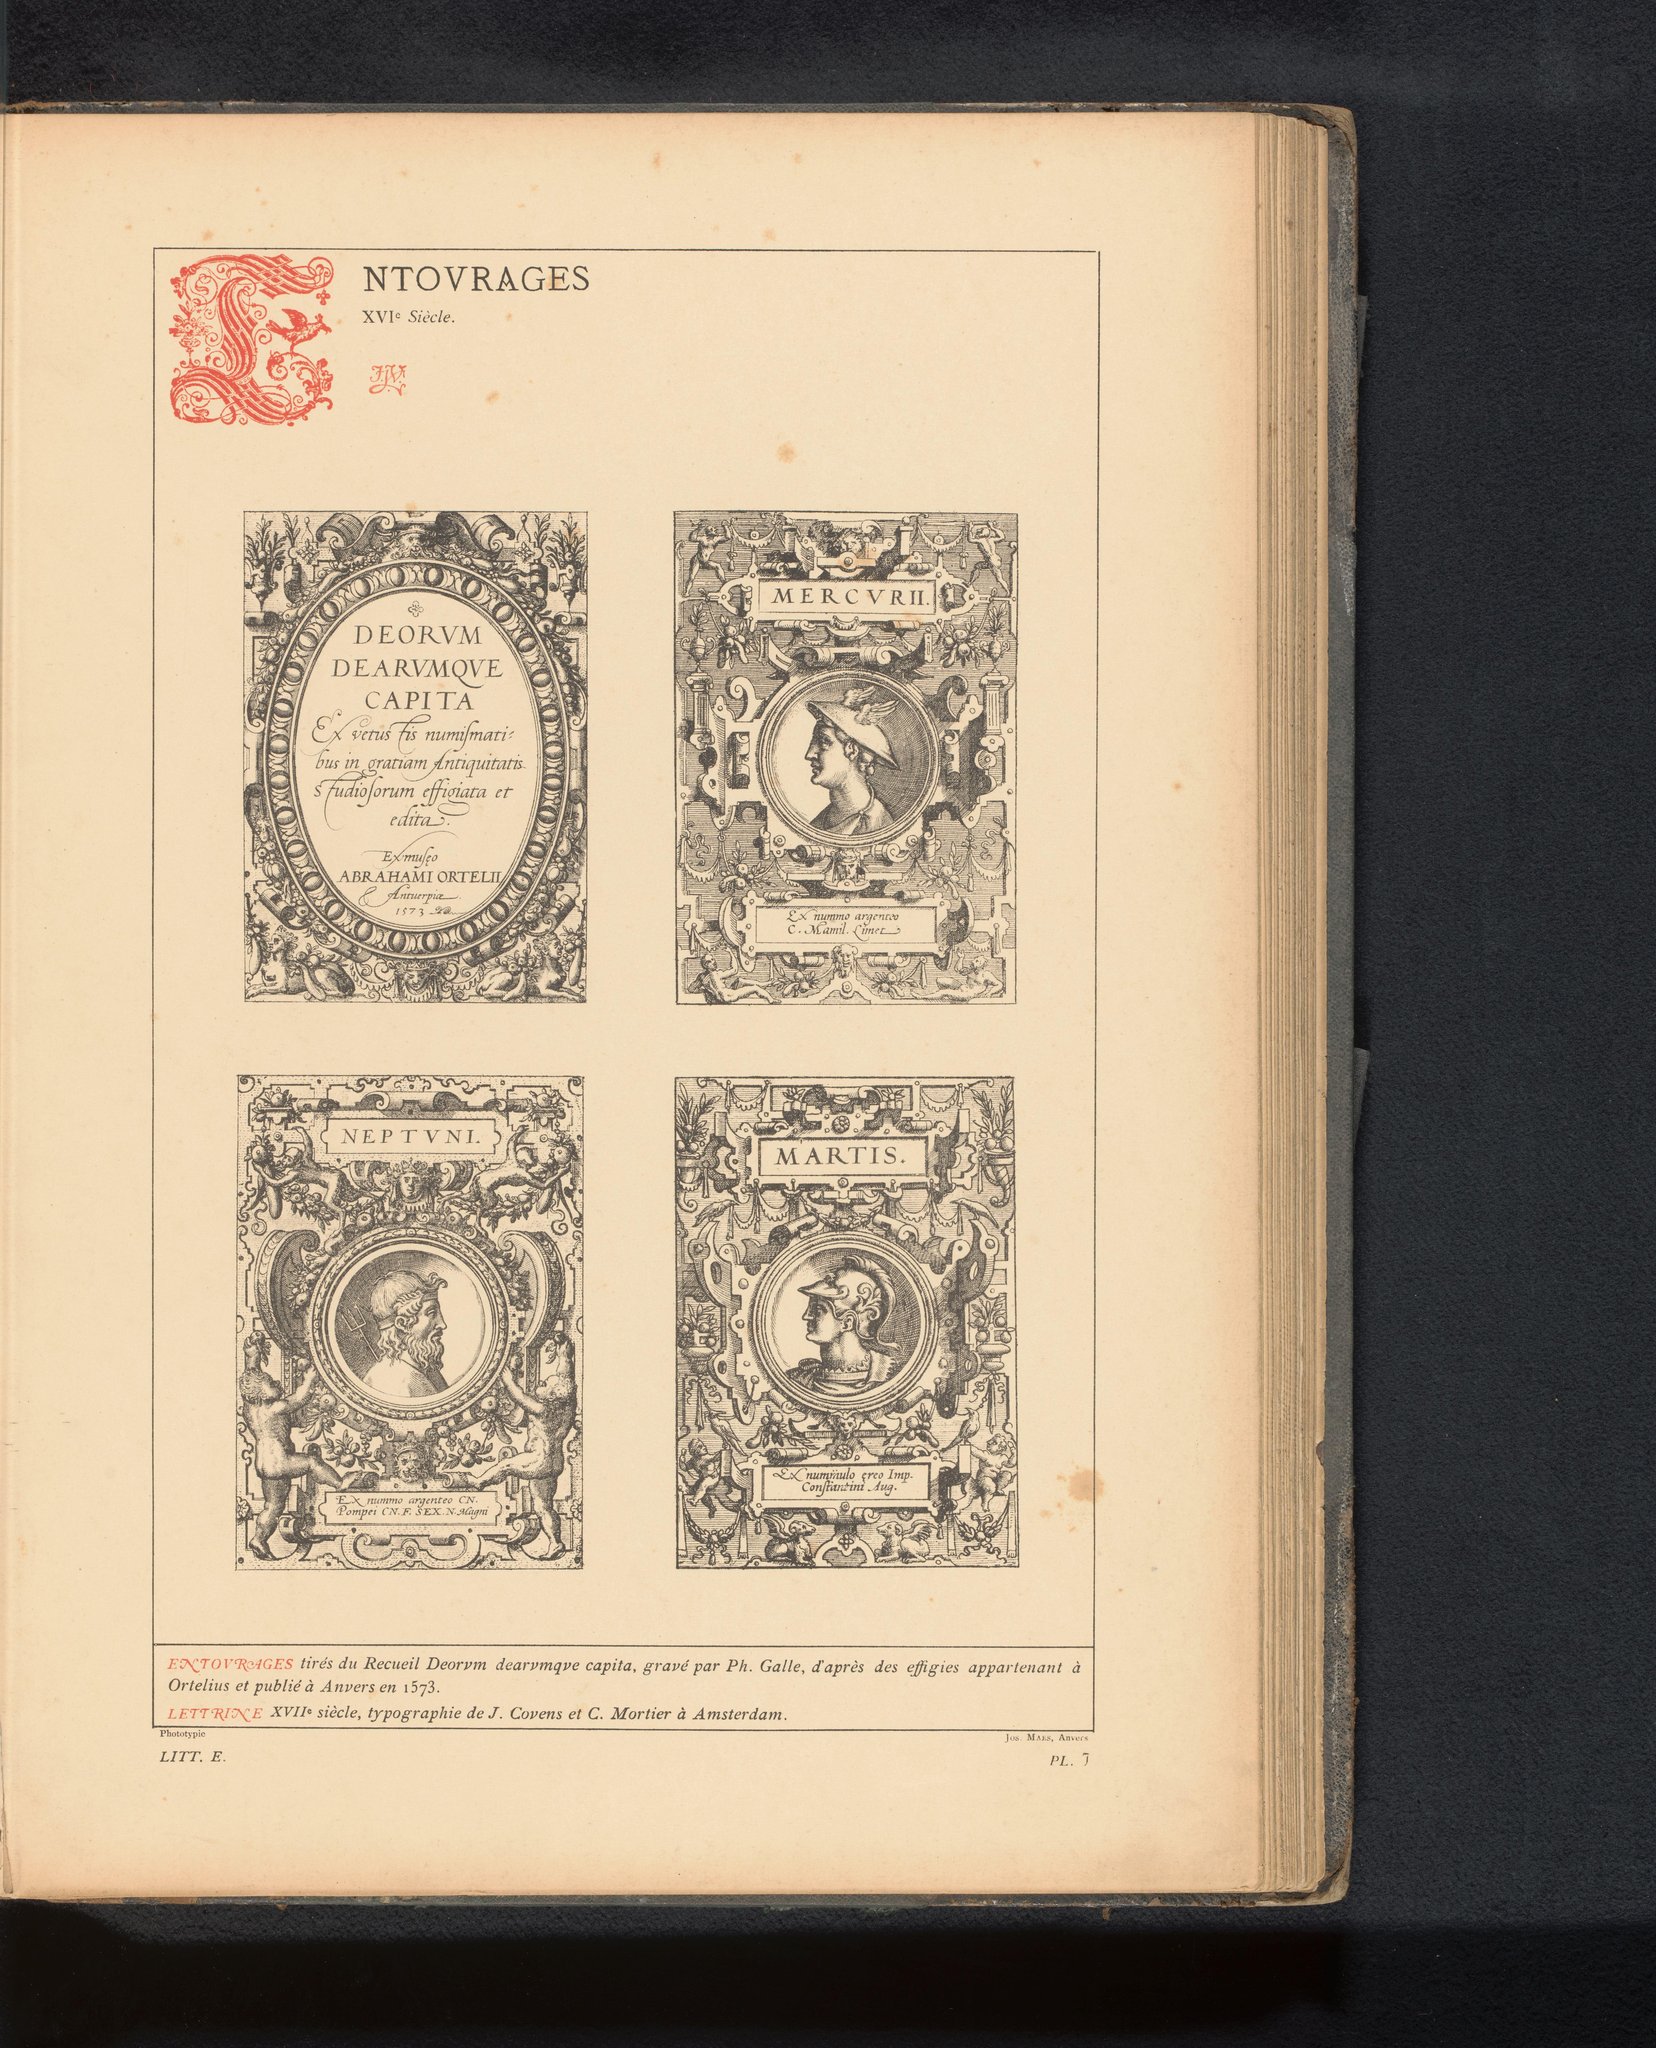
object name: reproduction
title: Entourages, XVIe Siècle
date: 1875-1880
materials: paper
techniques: photolithography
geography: amsterdam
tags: (story of) neptune (poseidon), (story of) mars (ares), decoration of printed matter, (story of) mercury (hermes)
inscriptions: inscription: ‘ENTOURAGES tirés du (...)’, inscription: ‘LITT. E. - PL. 7’, monogram: ‘JJvY’